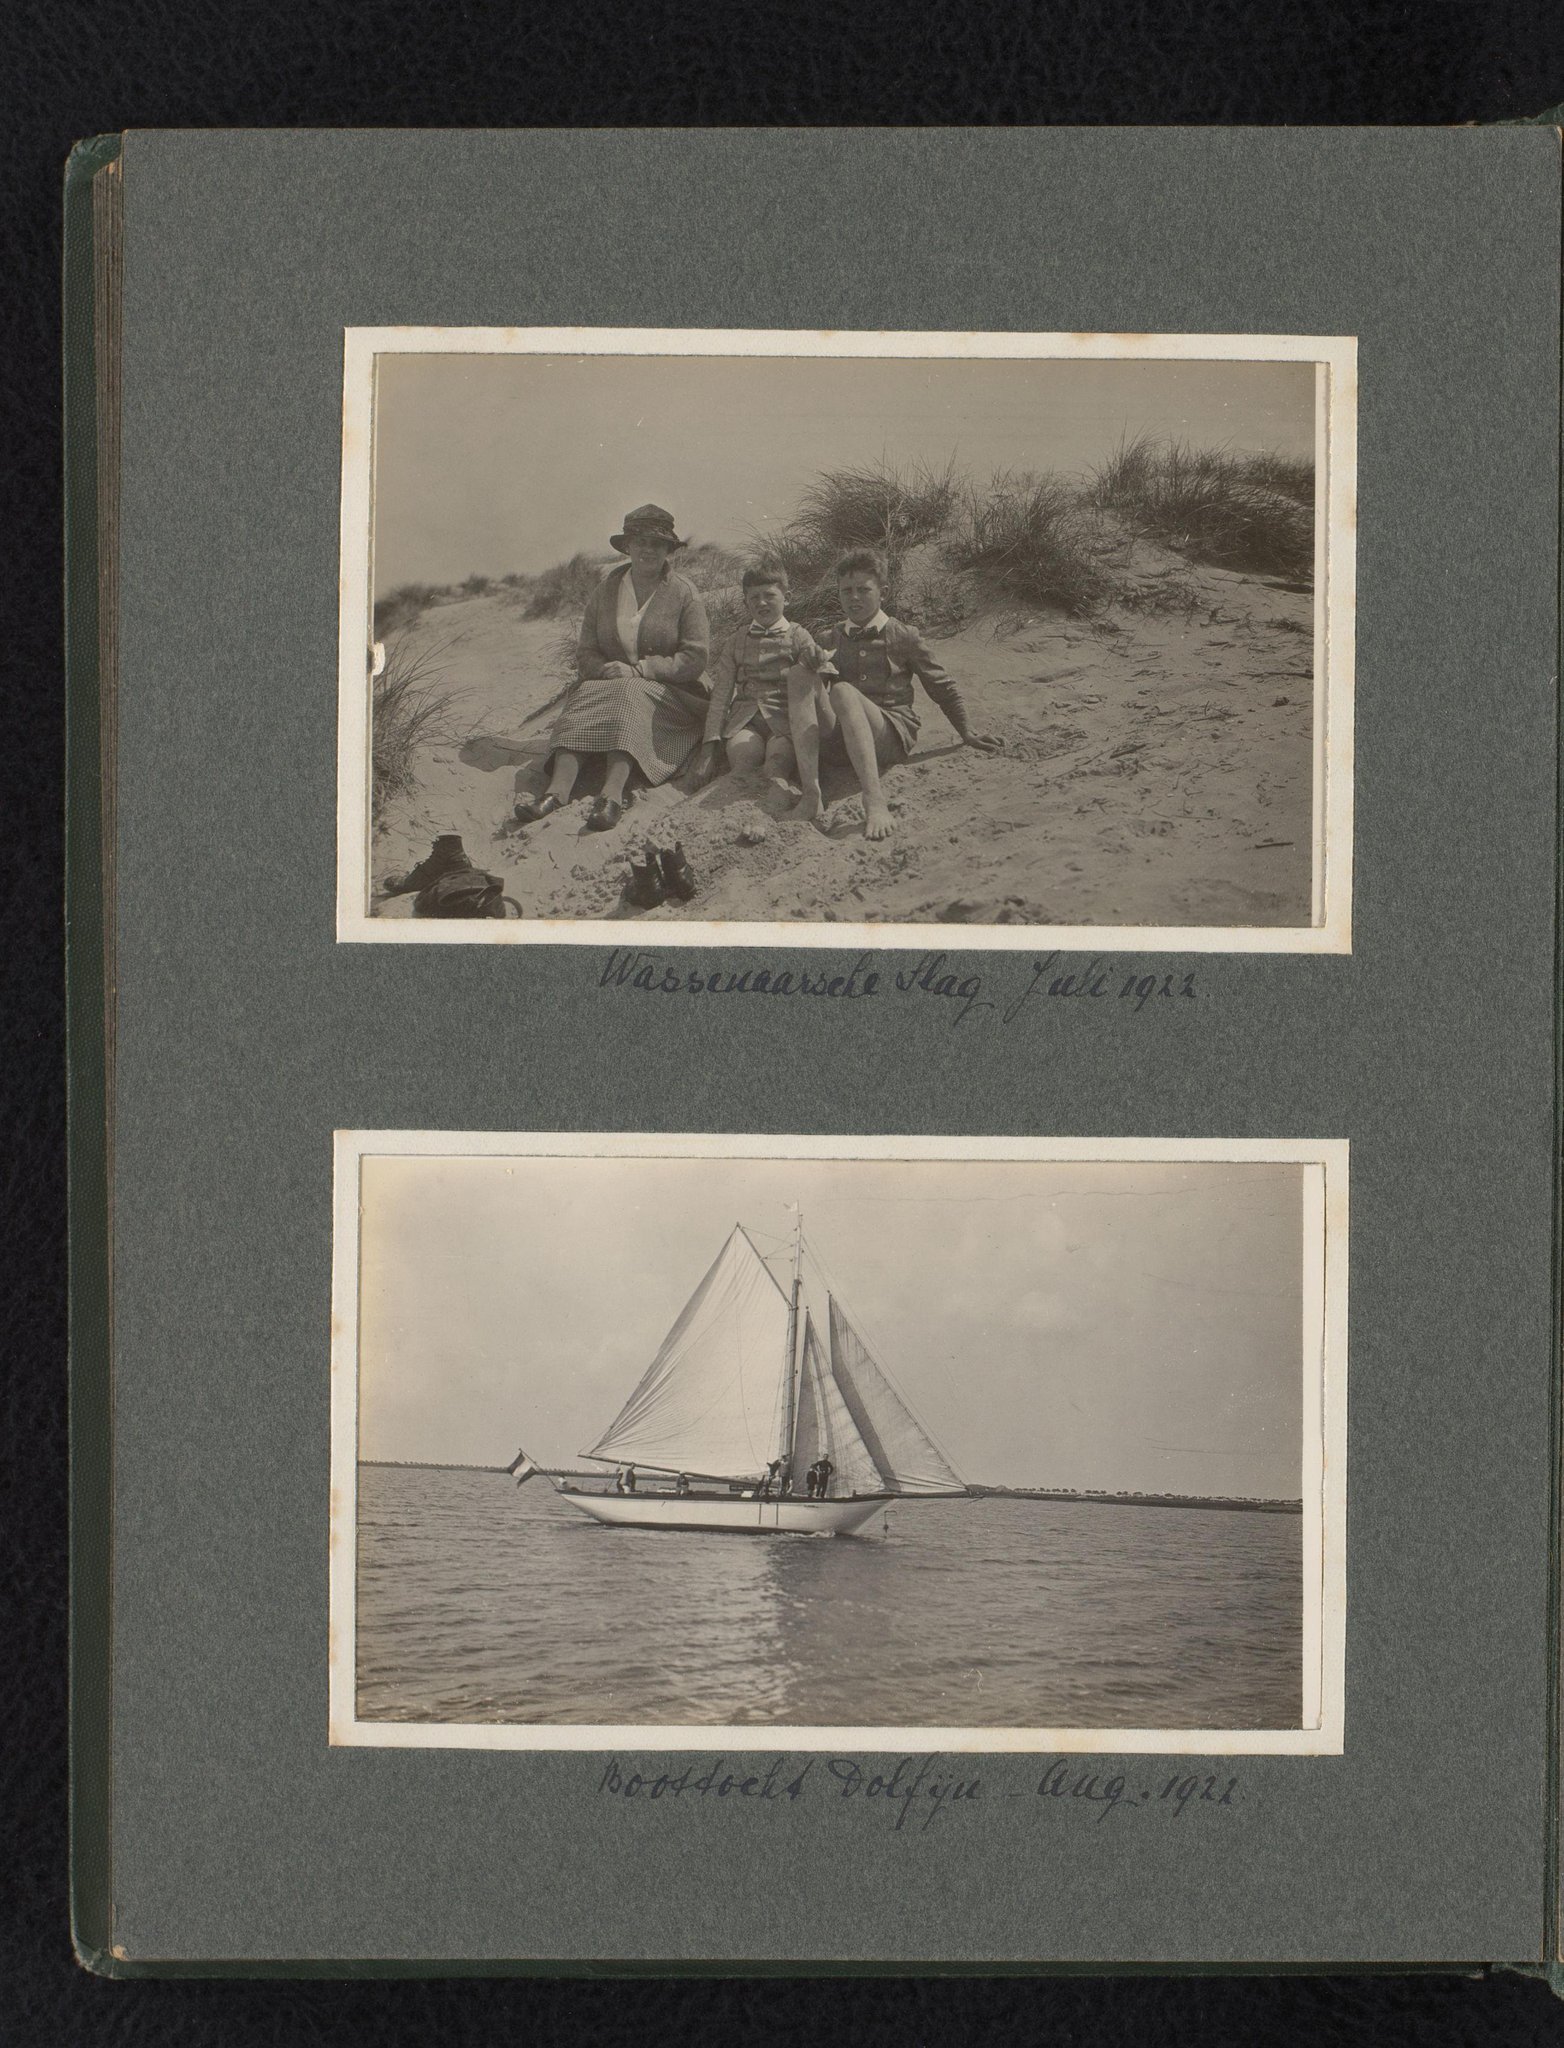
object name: photograph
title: Twee foto's van Caroline, Frank en Cay op het strand bij de Wassenaarse Slag en de zeilboot Dolfijn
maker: hendrik herman van den berg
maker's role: amateurfotograaf, jurist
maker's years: 1875-1944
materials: paper, cardboard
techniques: gelatin silver print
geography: wassenaar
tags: the hague, caroline louise van den berg-van den berg, carel frederik van den berg (cay), amsterdam, frank willem van den berg (1912-1998), beach (as place of recreation), sailing-ship, sailing-boat, historical persons, family life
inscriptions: caption: ‘Wassenaarsche Slag Juli 1922/ Boottocht Dolfijn Juli 1922’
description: Deze foto's maken deel uit van een album.